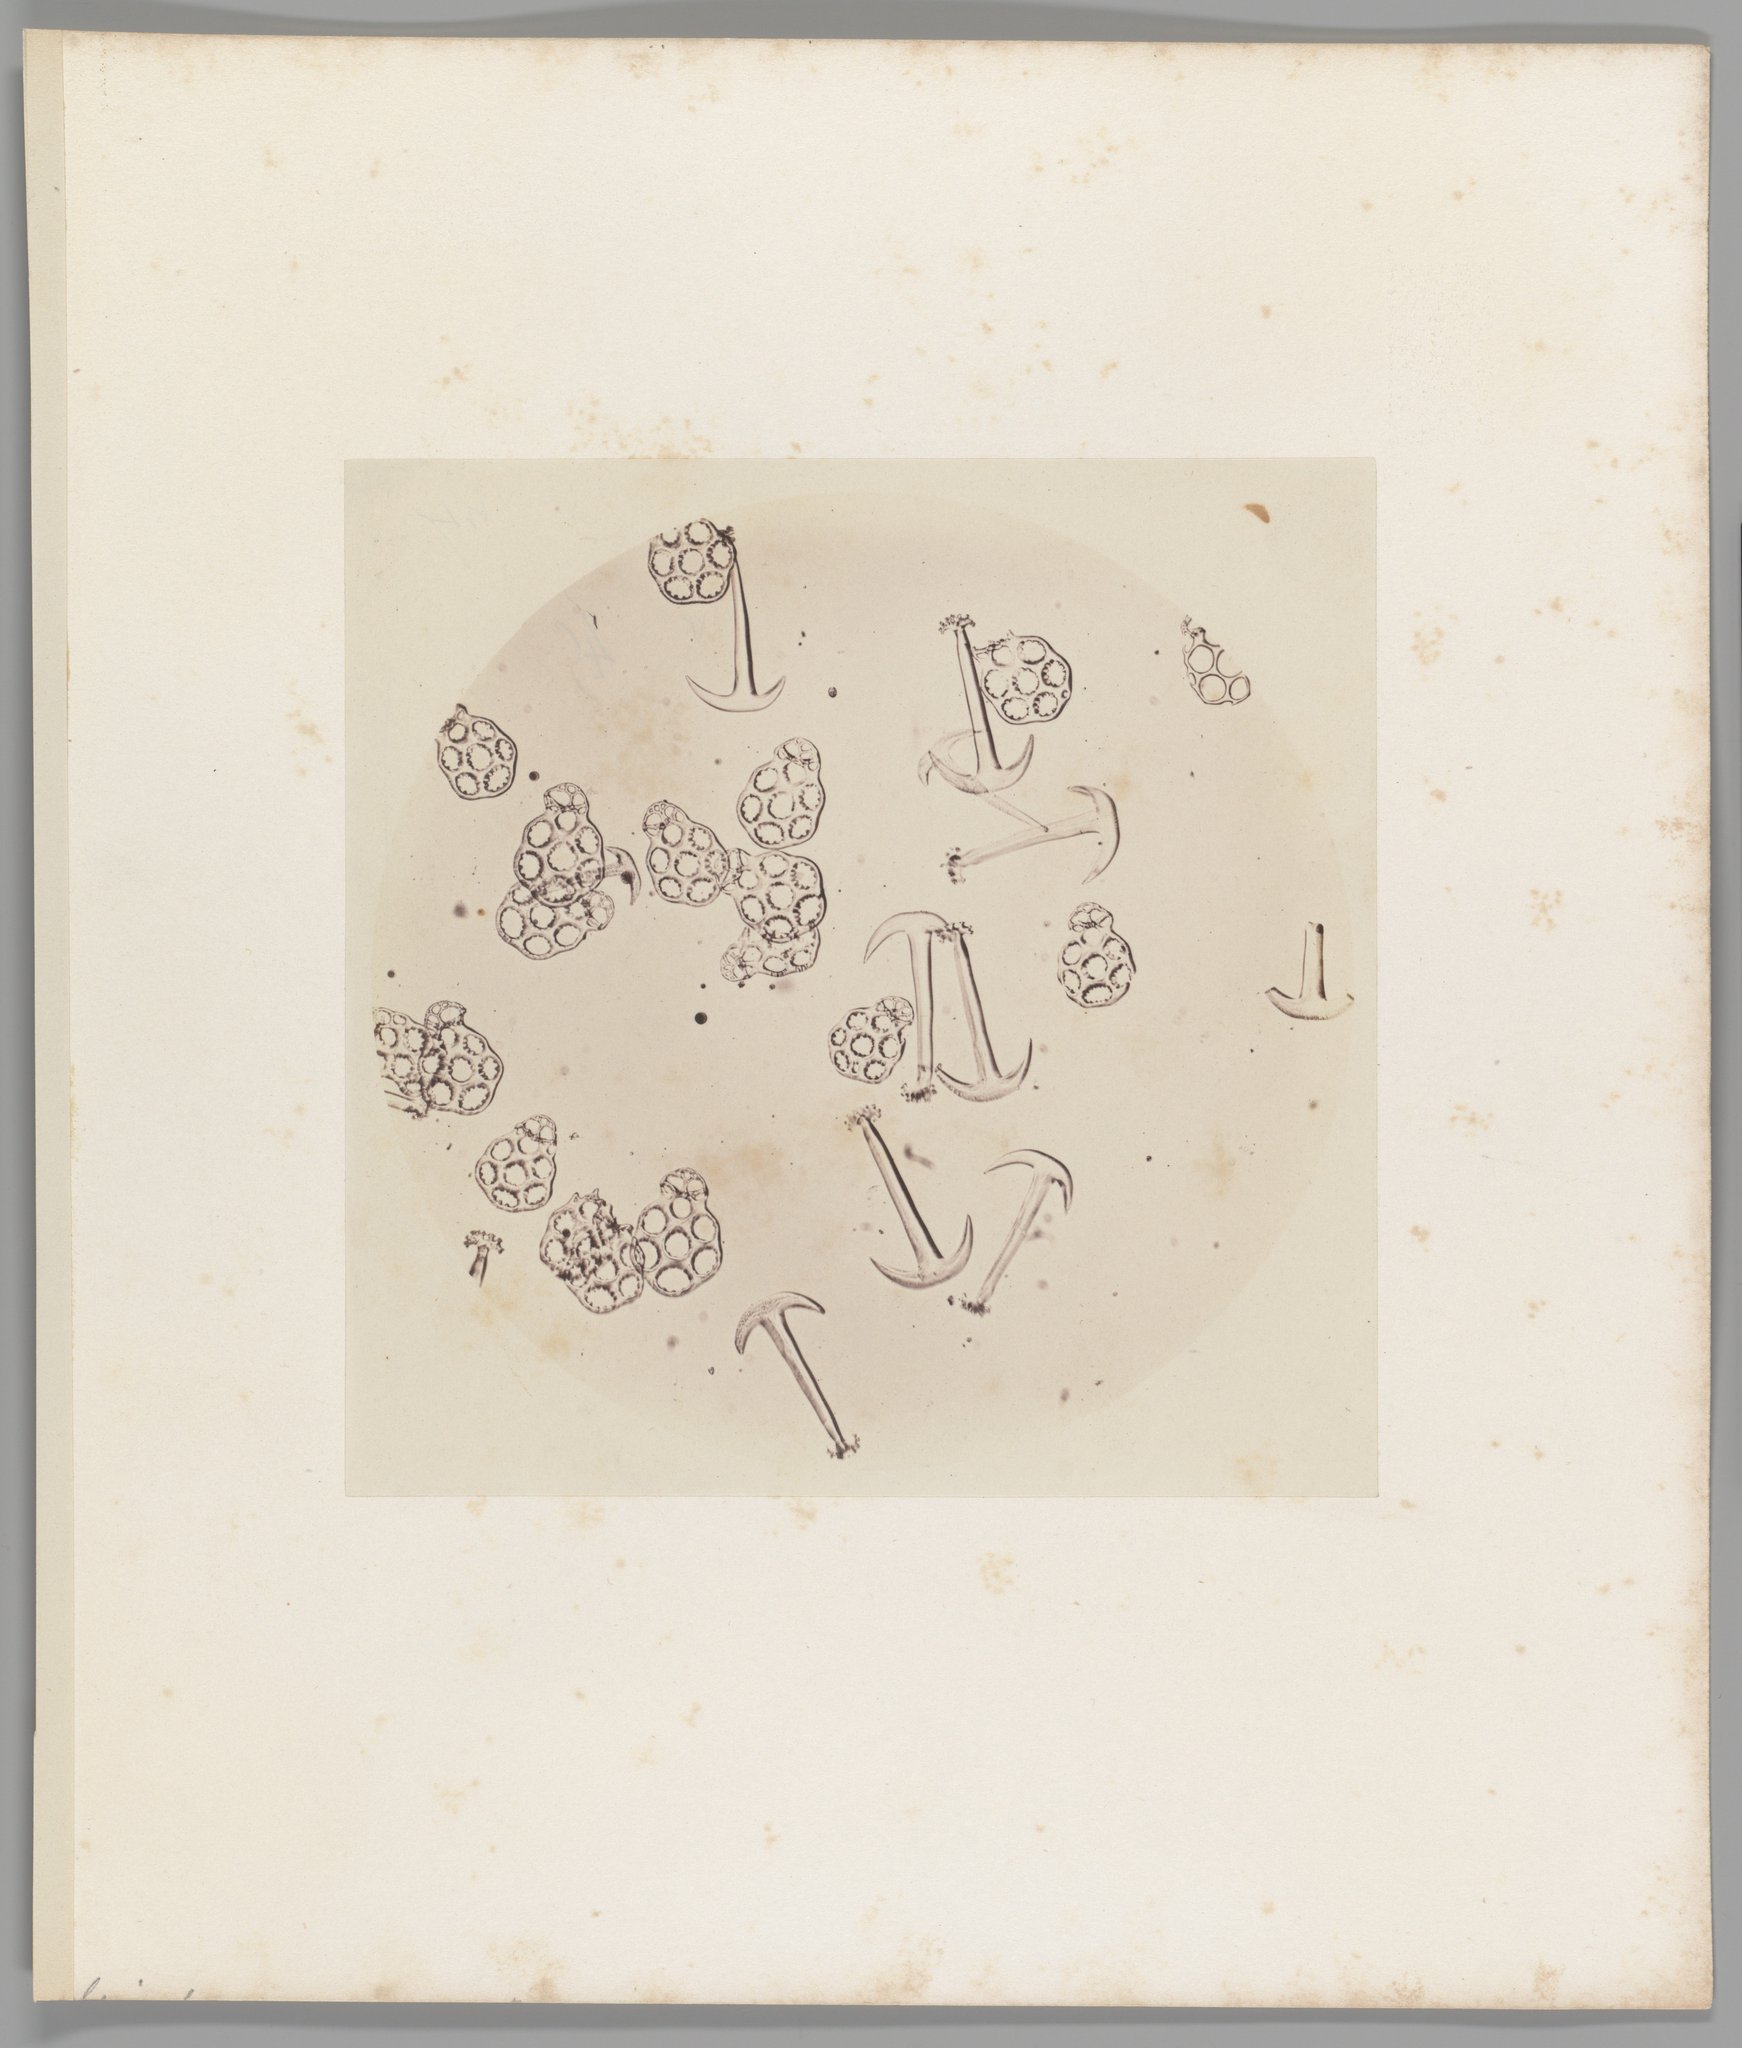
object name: photograph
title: [Untitled]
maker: auguste-adolphe bertsch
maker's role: artist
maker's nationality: french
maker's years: 1813-1871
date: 1853-1857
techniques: salted paper print